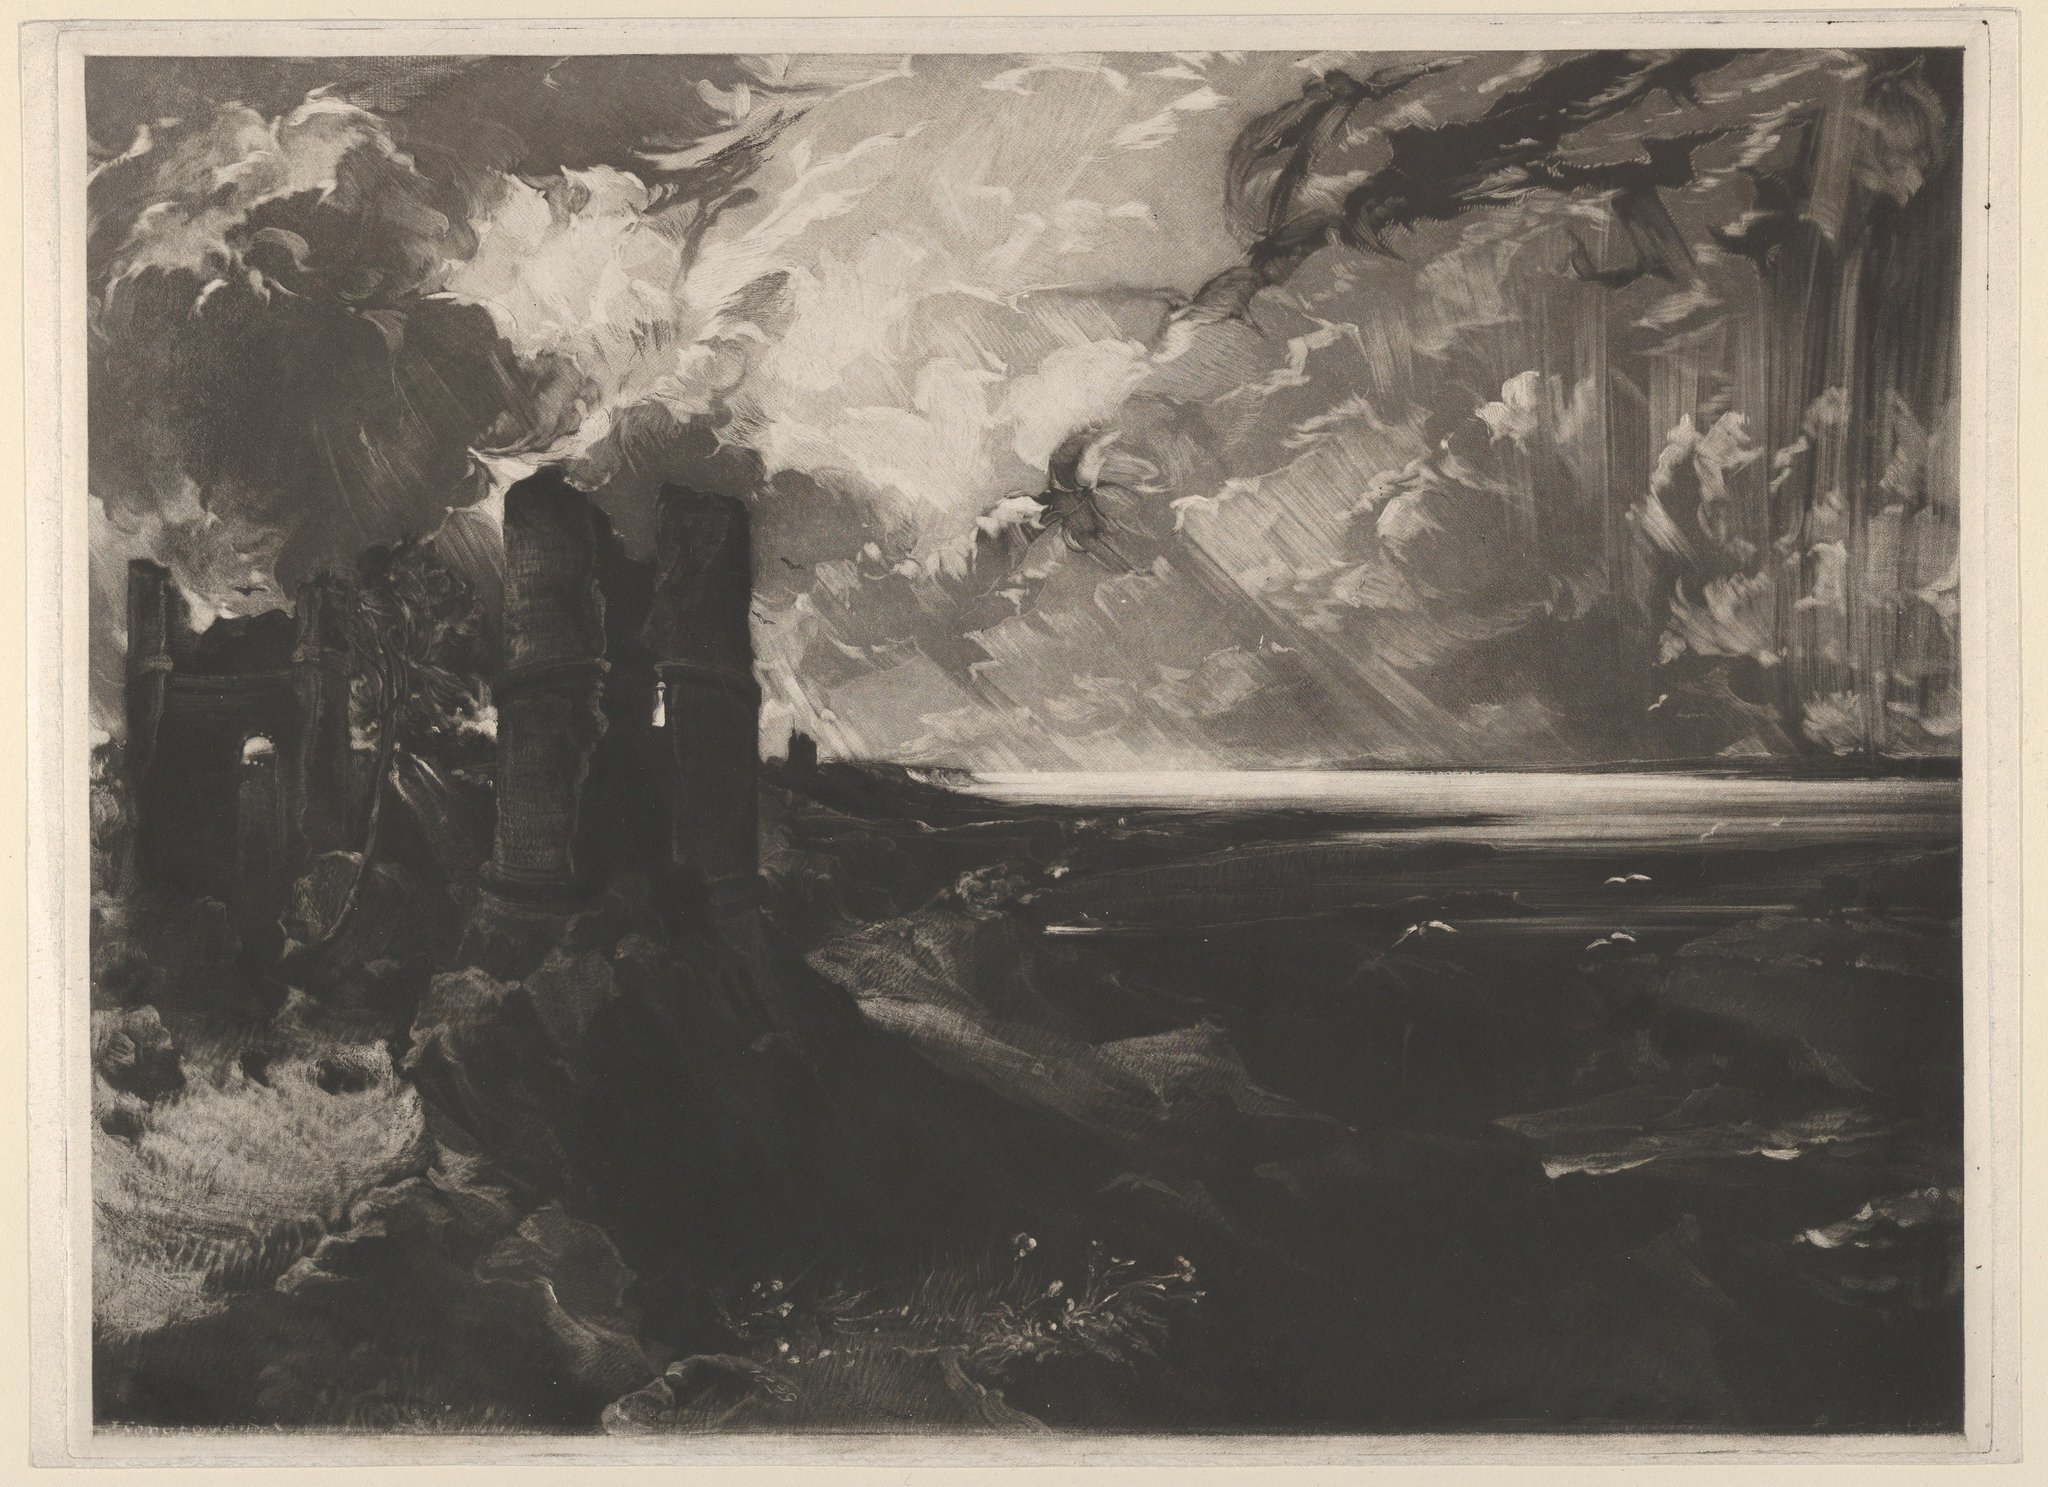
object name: print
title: Hadleigh Castle: Large Plate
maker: david lucas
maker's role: artist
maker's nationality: british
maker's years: 1802-1881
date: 1830-1849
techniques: mezzotint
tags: castles